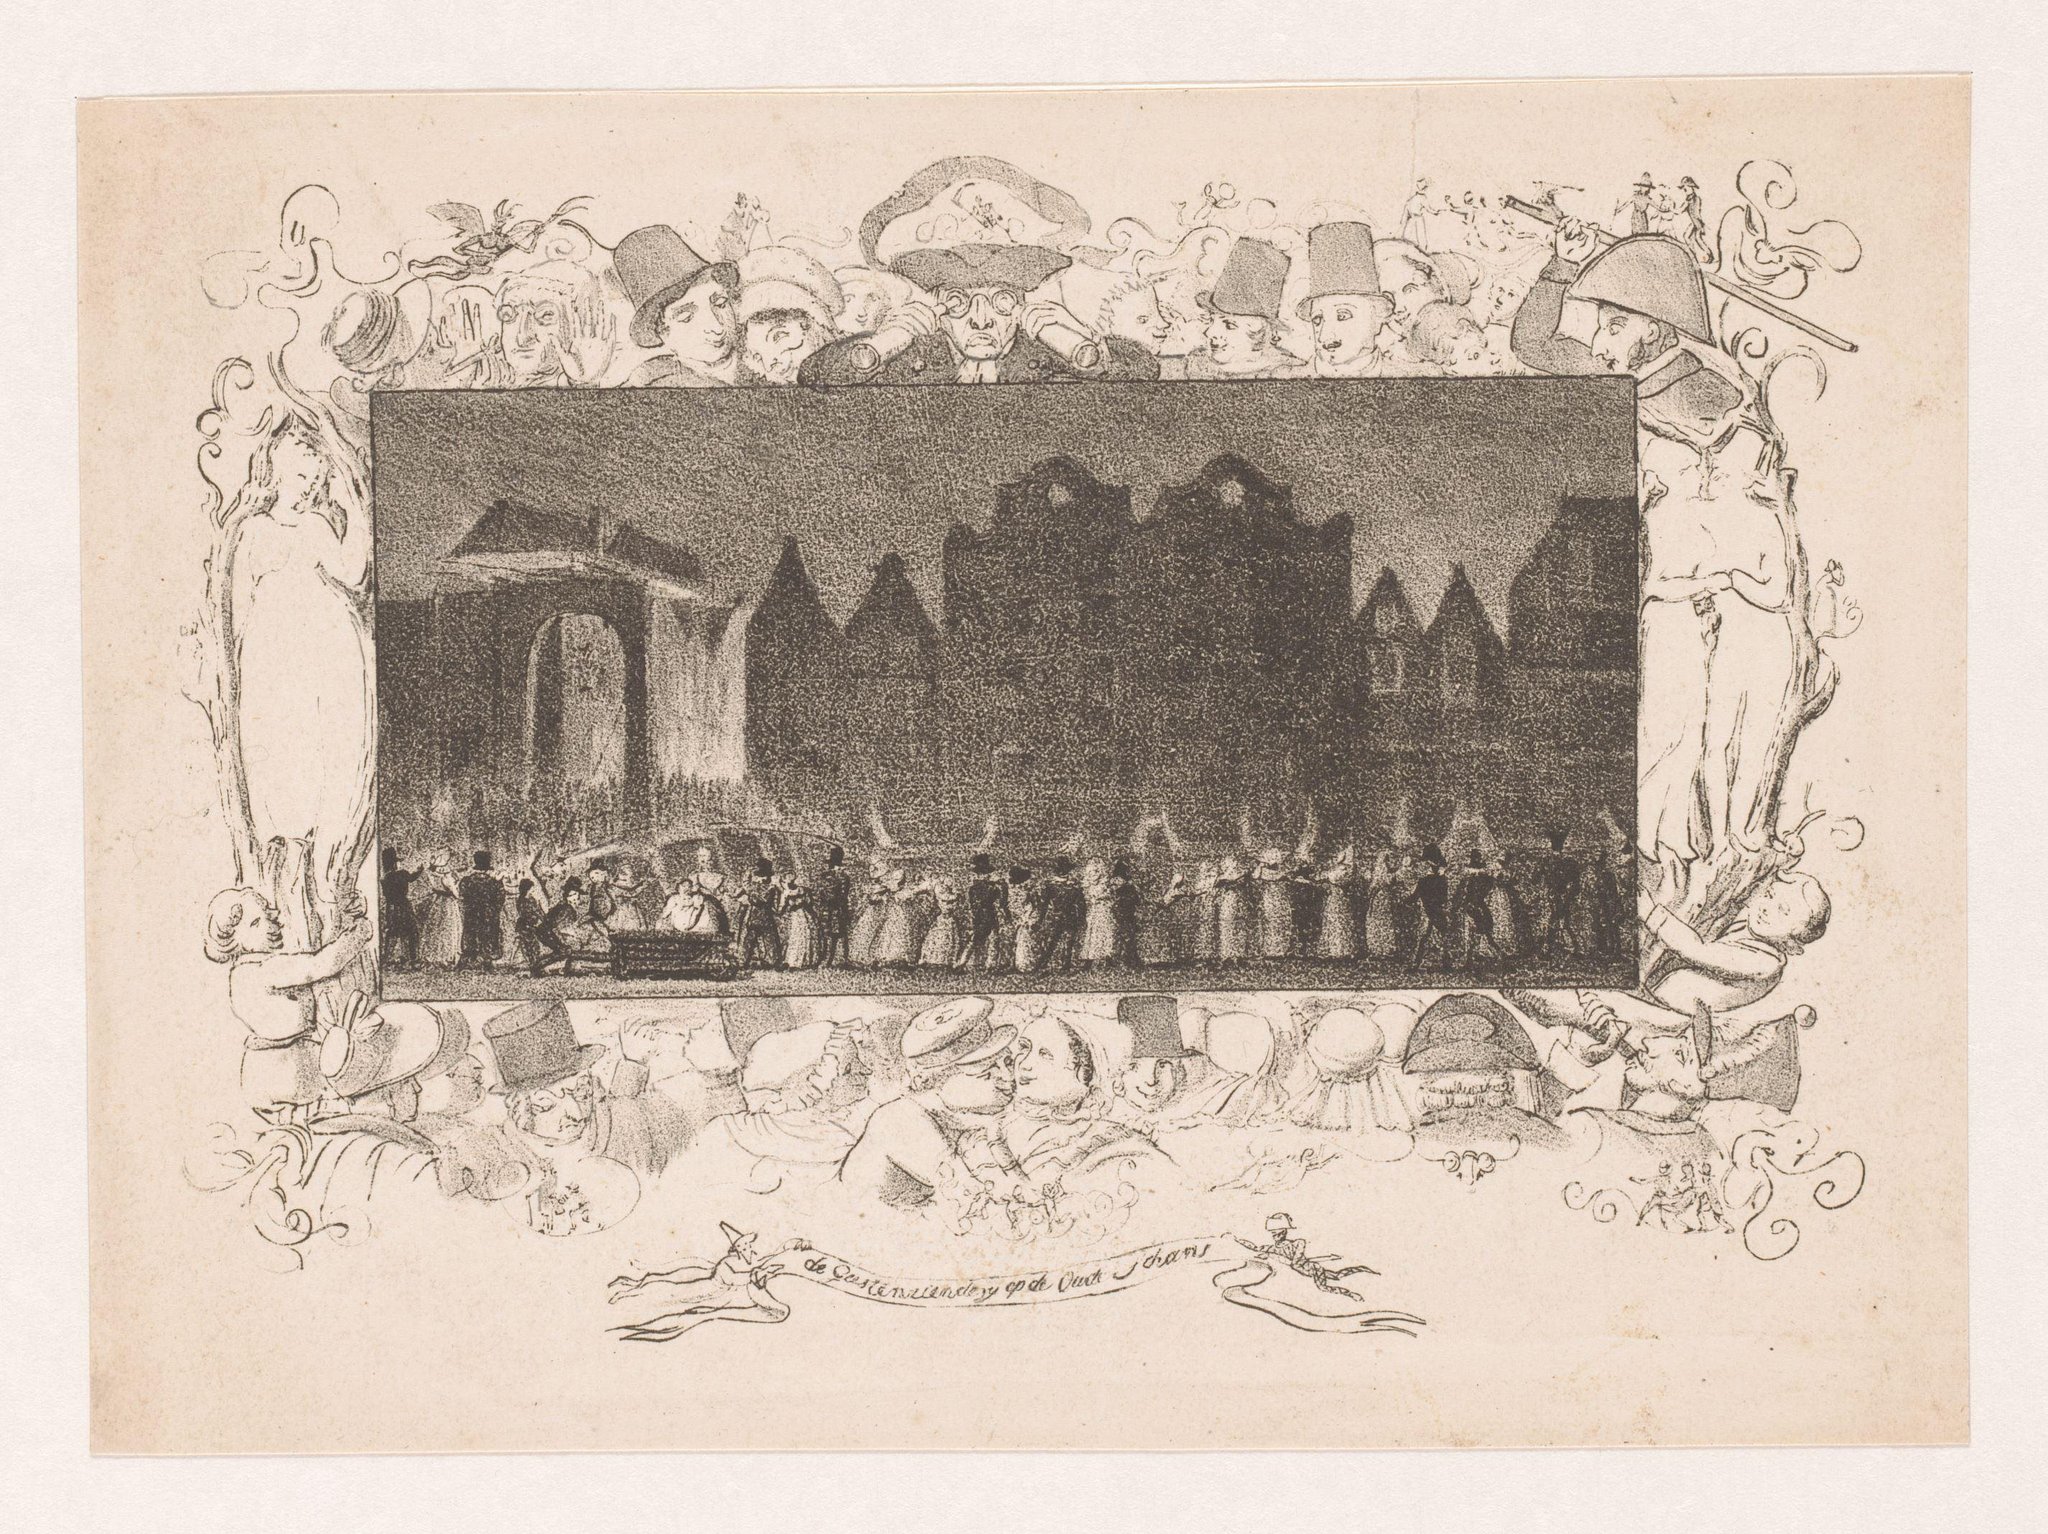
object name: print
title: Toeschouwers kijken naar de geestenverschijning op de Oude Schans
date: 1835-1839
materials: paper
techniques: lithograph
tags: materialization, appearance of spirit or ghost, student life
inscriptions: collector's mark: Lugt 2760, collector's mark: Lugt 2228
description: Verschijning van geesten op de Oudeschans te Amsterdam, in de avond van 8 en 9 oktober 1833. Langs de kade bewegen de spookachtige witte schimmen van vrouwen in lange gewaden. Op de voorgrond en op de brug de verzamelde toeschouwers. De 'geesten' werden voortgebracht door enige studenten met behulp van toverlantaarnplaten. De voorstelling is gevat in een randwerk met humoristische figuren: studenten, politieagent, kinderen en kussende figuren.